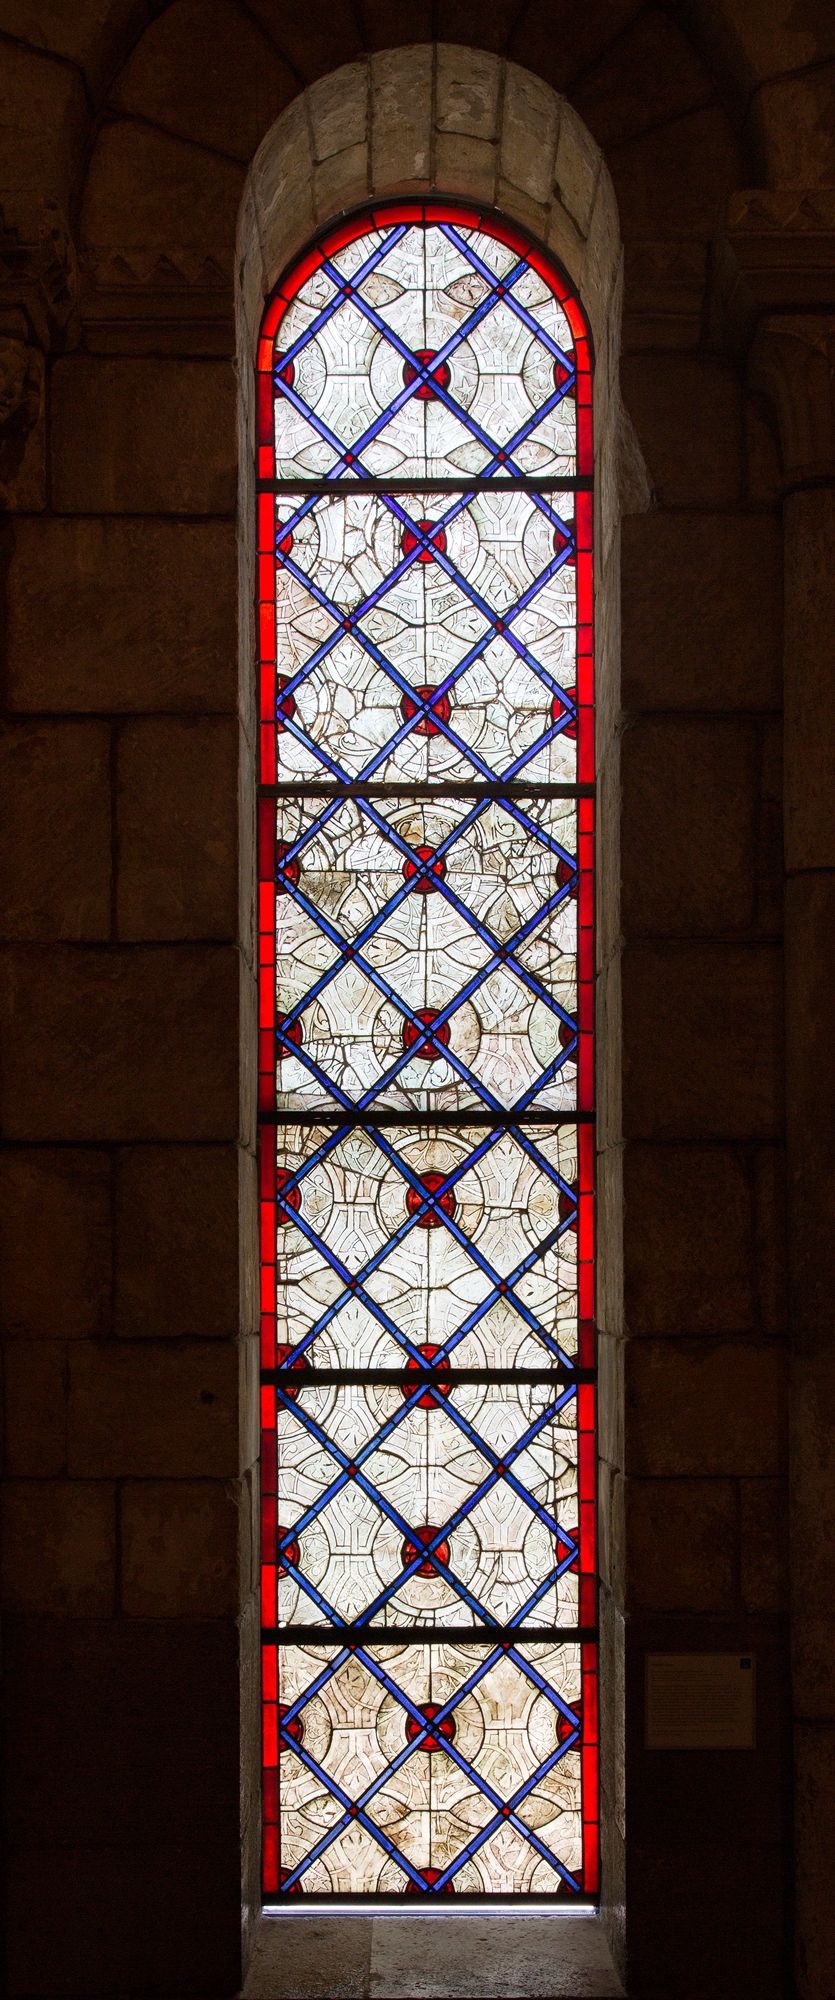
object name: stained glass panel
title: Grisaille Panels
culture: french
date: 1270-1280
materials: glass, metal, paint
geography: france